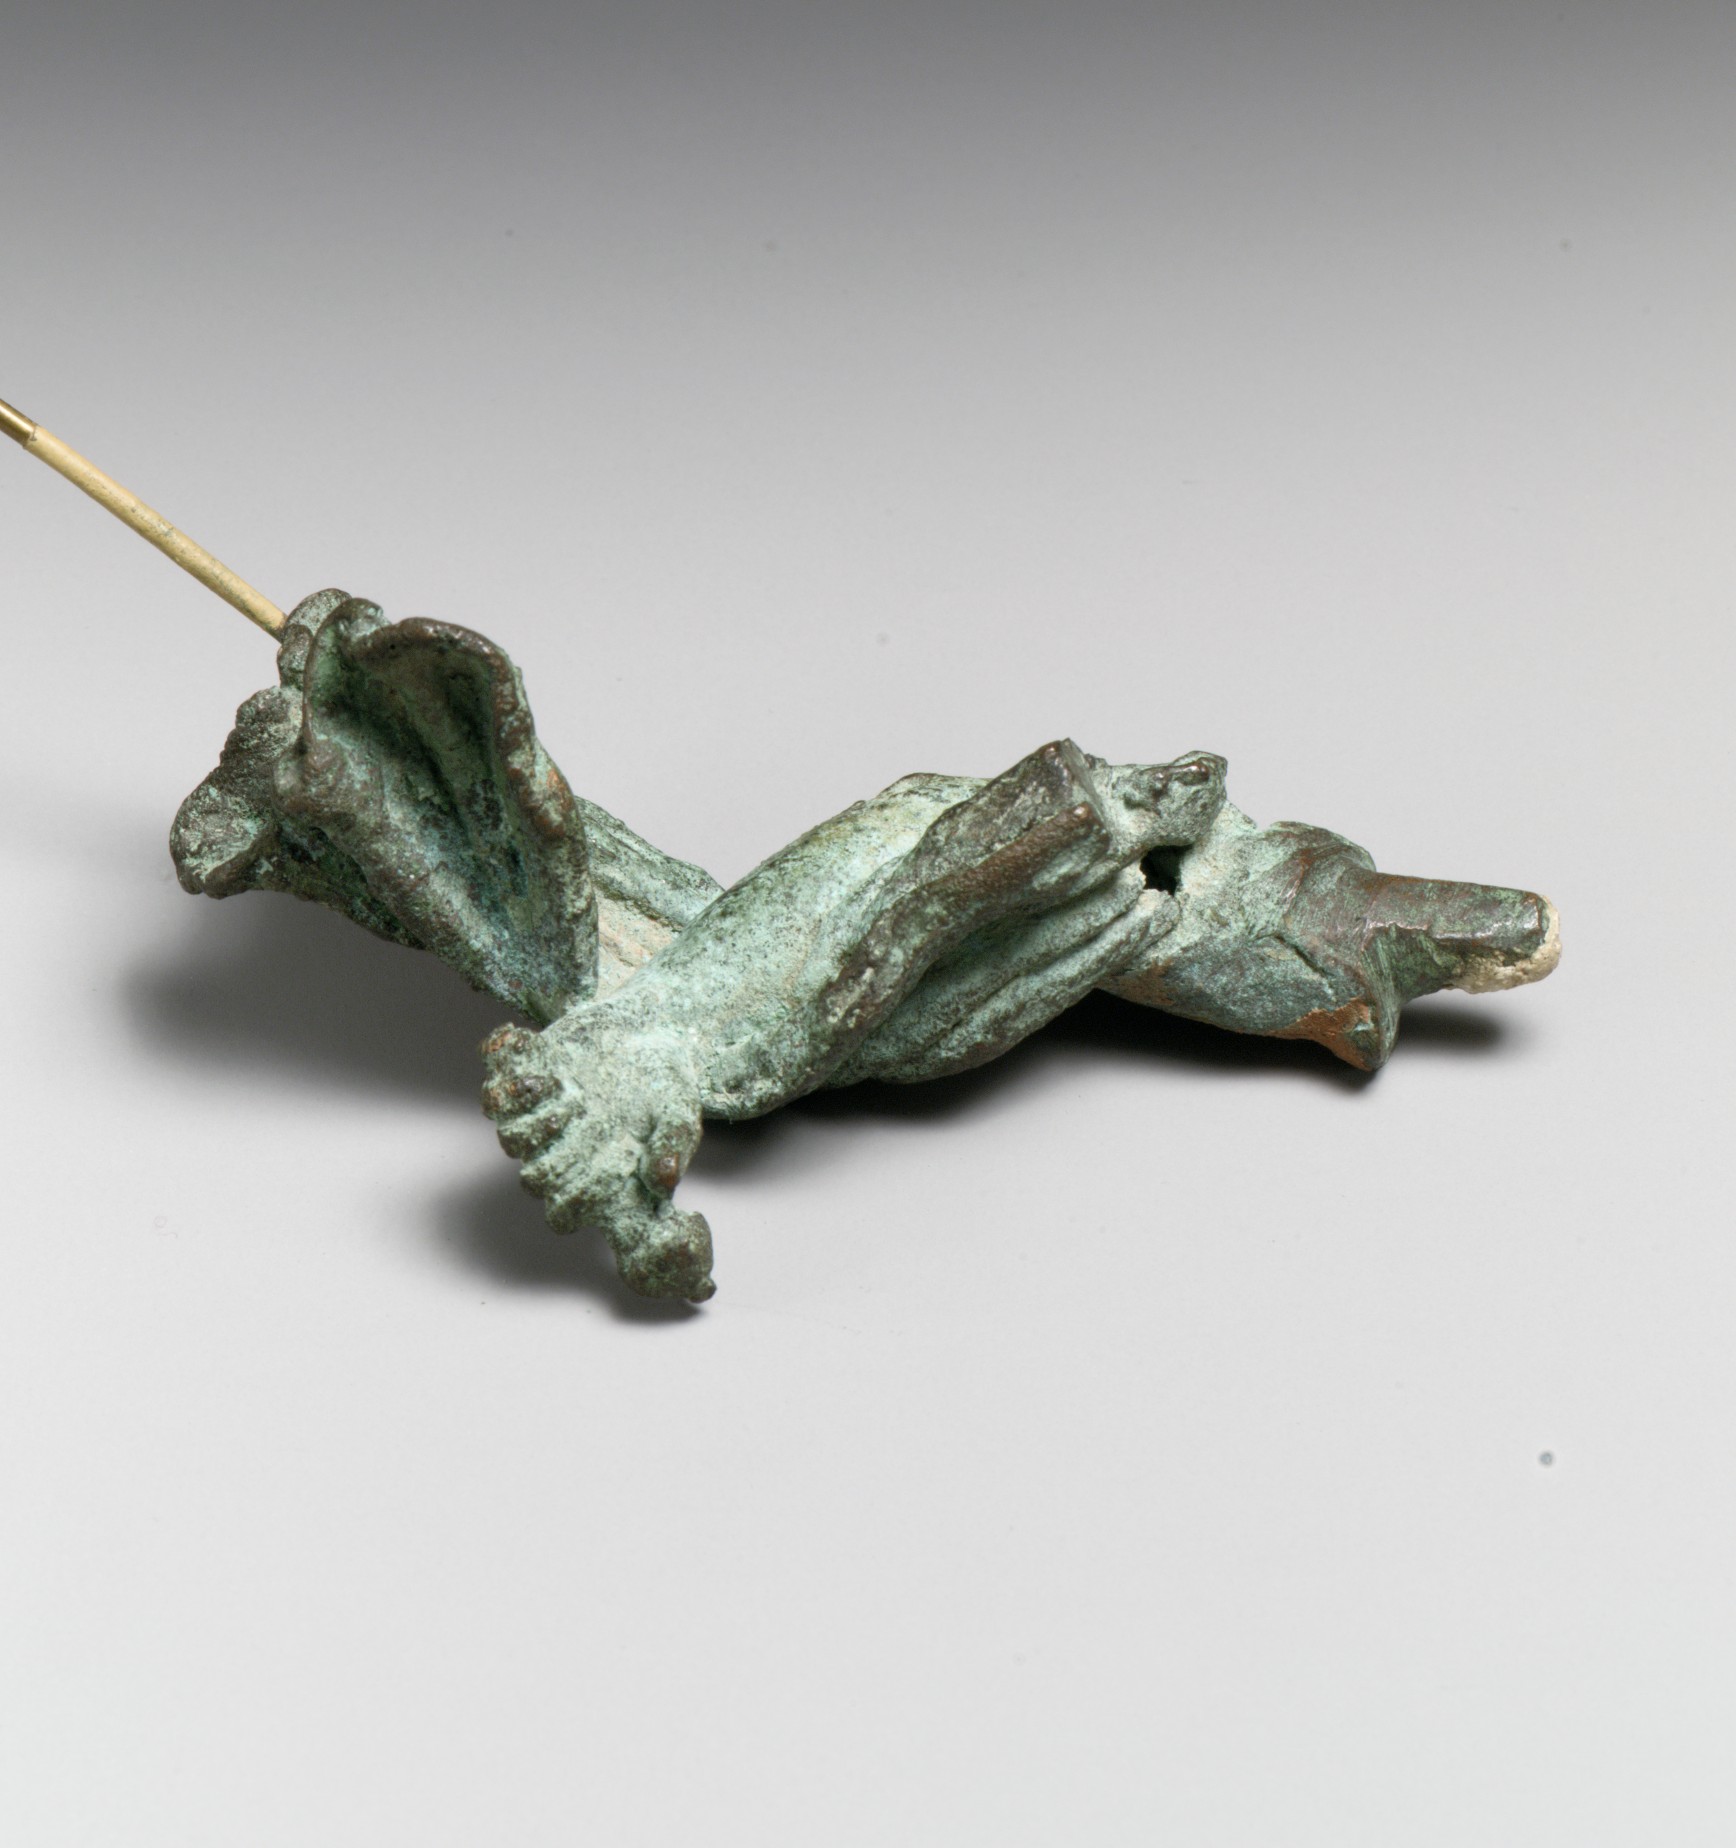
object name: arm and hand from statuette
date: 7000 BCE-330 CE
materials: bronze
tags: hands